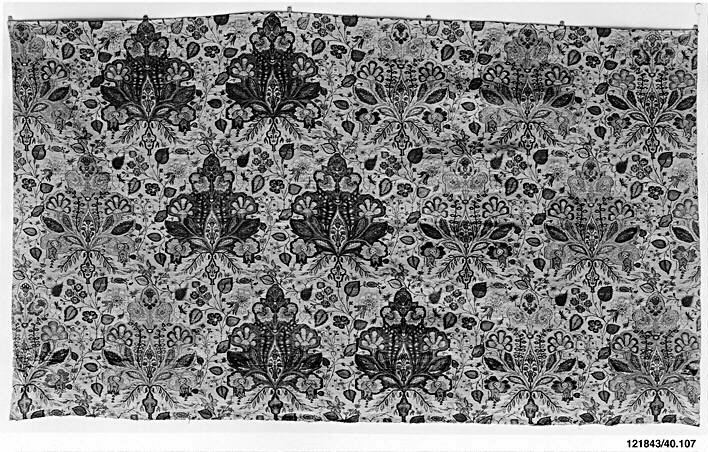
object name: textile fragment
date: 1601-1700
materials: wool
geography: iran